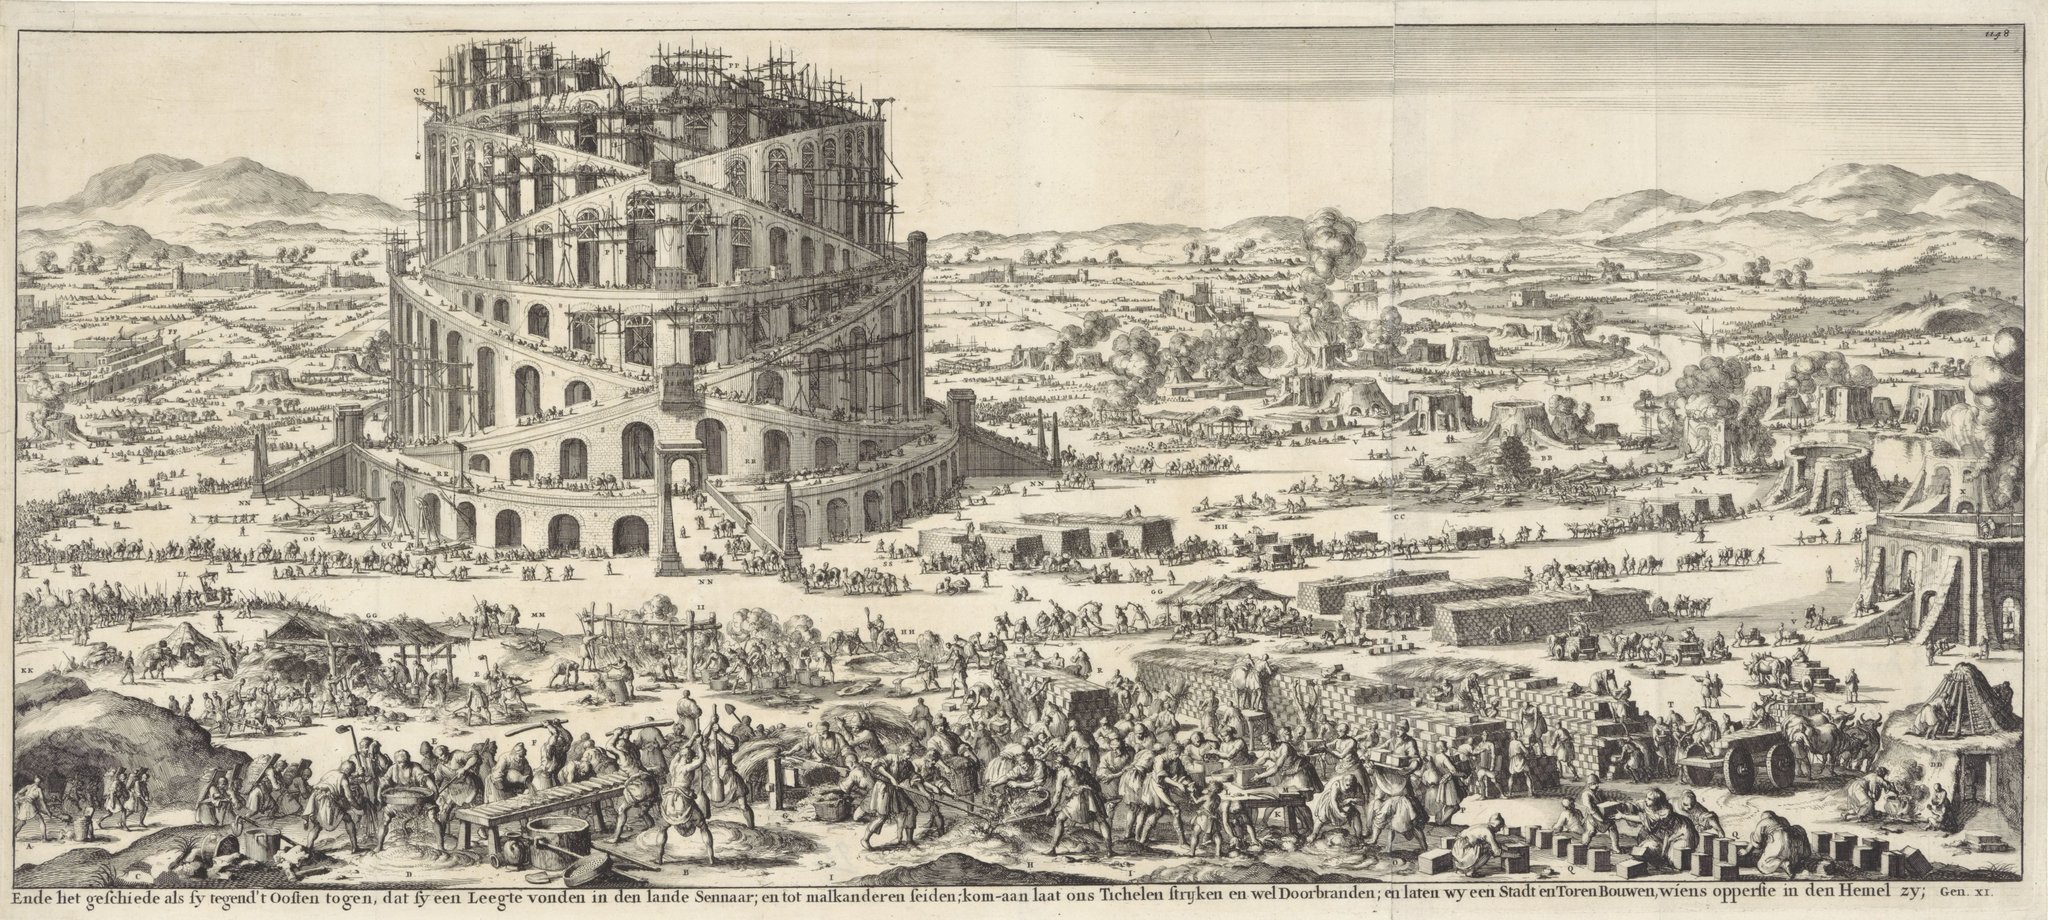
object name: print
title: Bouw van de toren van Babel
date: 1690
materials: paper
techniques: etching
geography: amsterdam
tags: the building of the tower of babel; nimrod may be present, supervising or assisting the construction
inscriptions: collector's mark: Lugt 2228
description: De toren van Babel wordt gebouwd. Op de voorgrond mannen die muren metselen en ovens die hoog op worden gestookt. Onder de voorstelling een verwijzing naar de Bijbeltekst in Gen. 11.